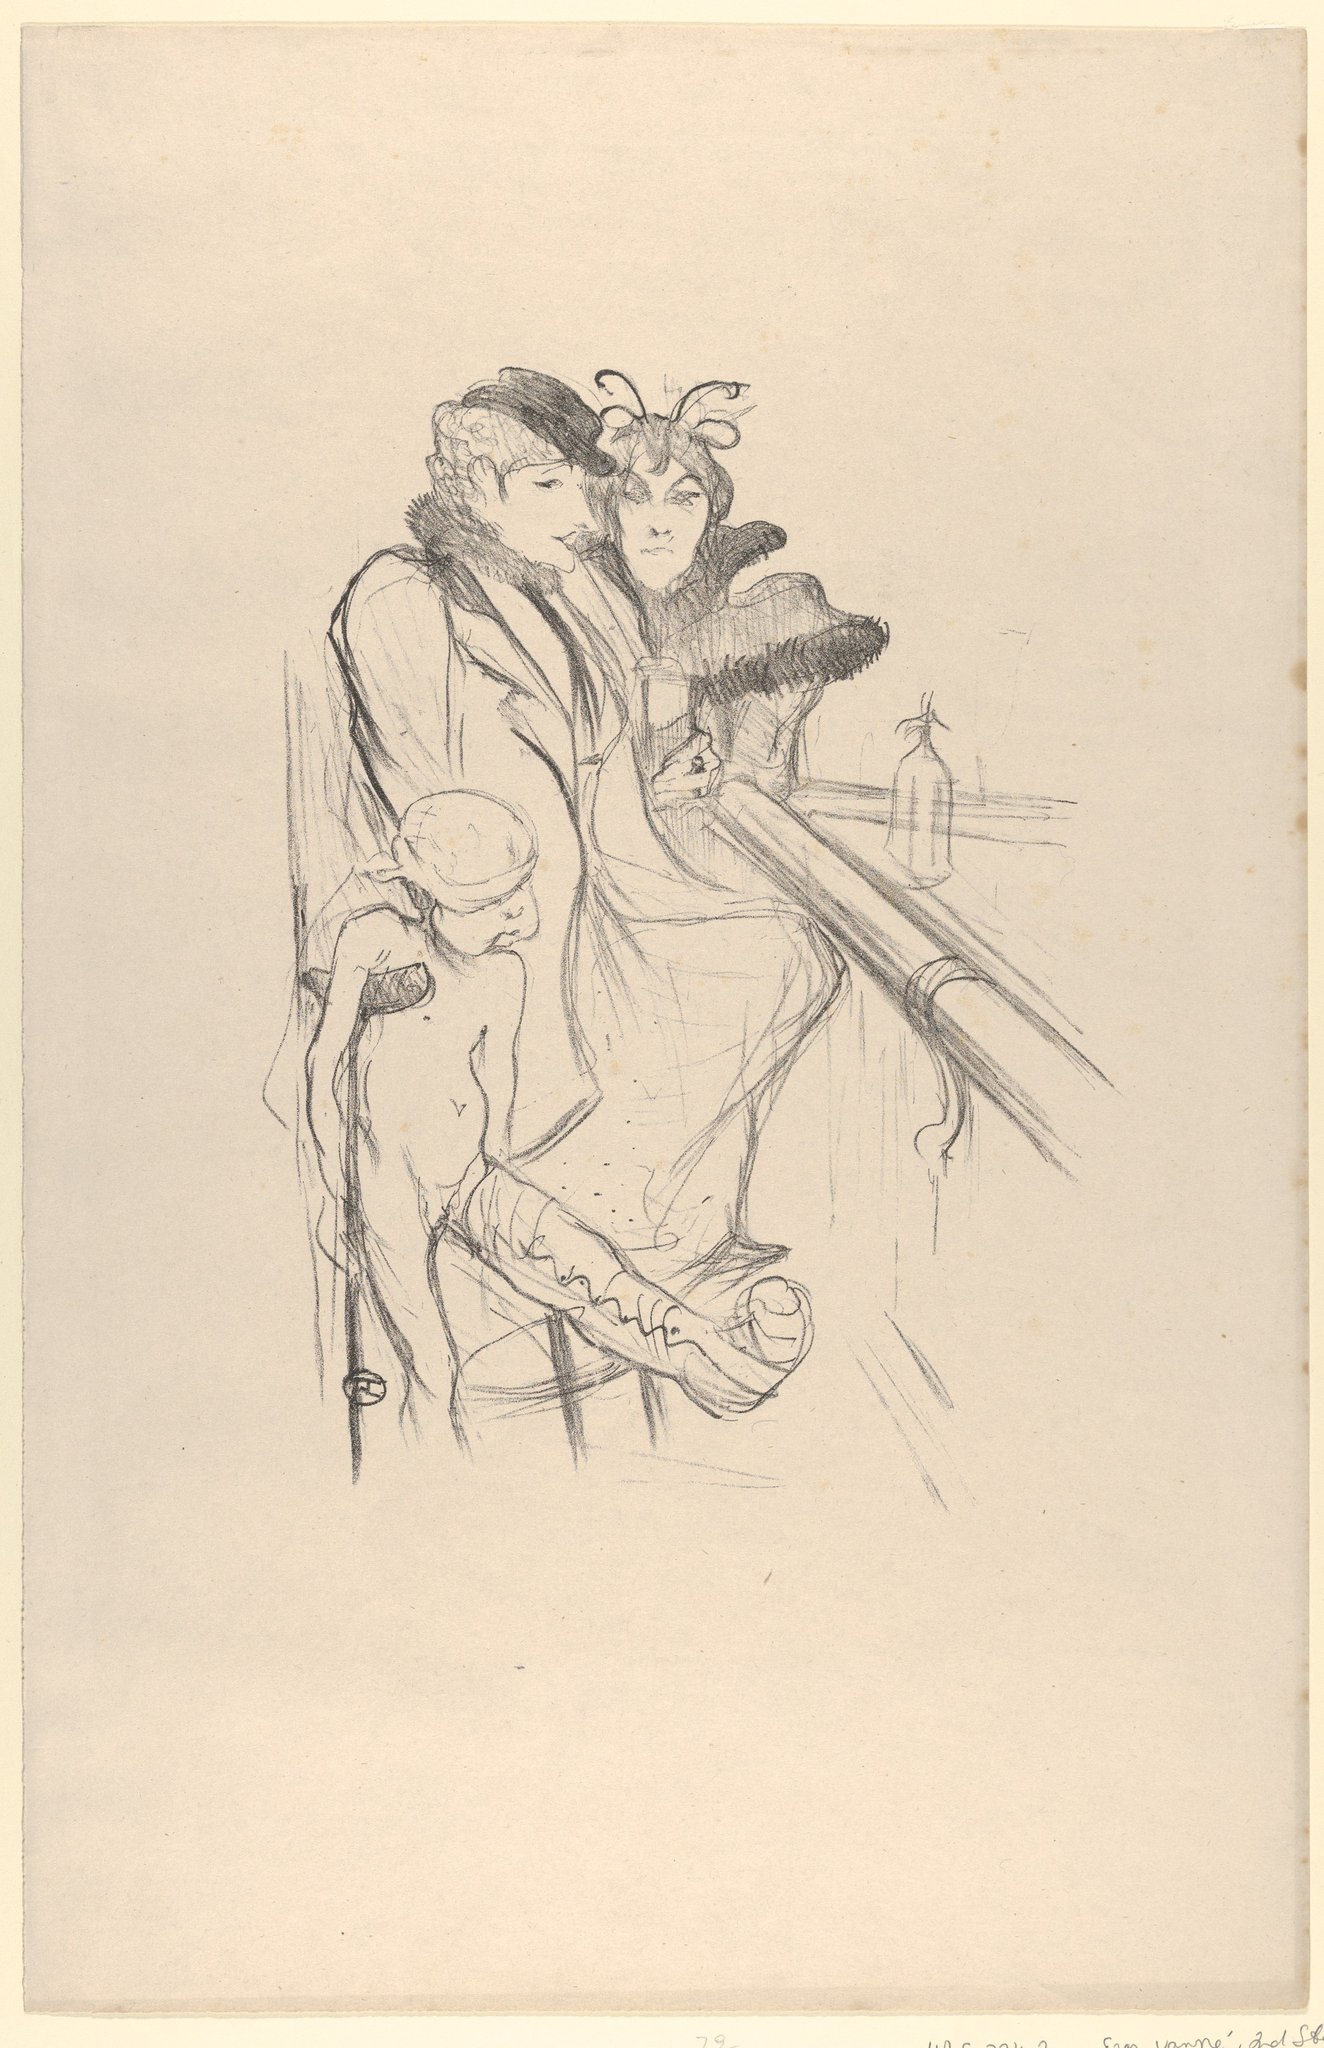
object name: print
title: Eros Vanquished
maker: henri de toulouse-lautrec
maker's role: artist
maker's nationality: french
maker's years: 1864-1901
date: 1894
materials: paper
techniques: lithograph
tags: men,women